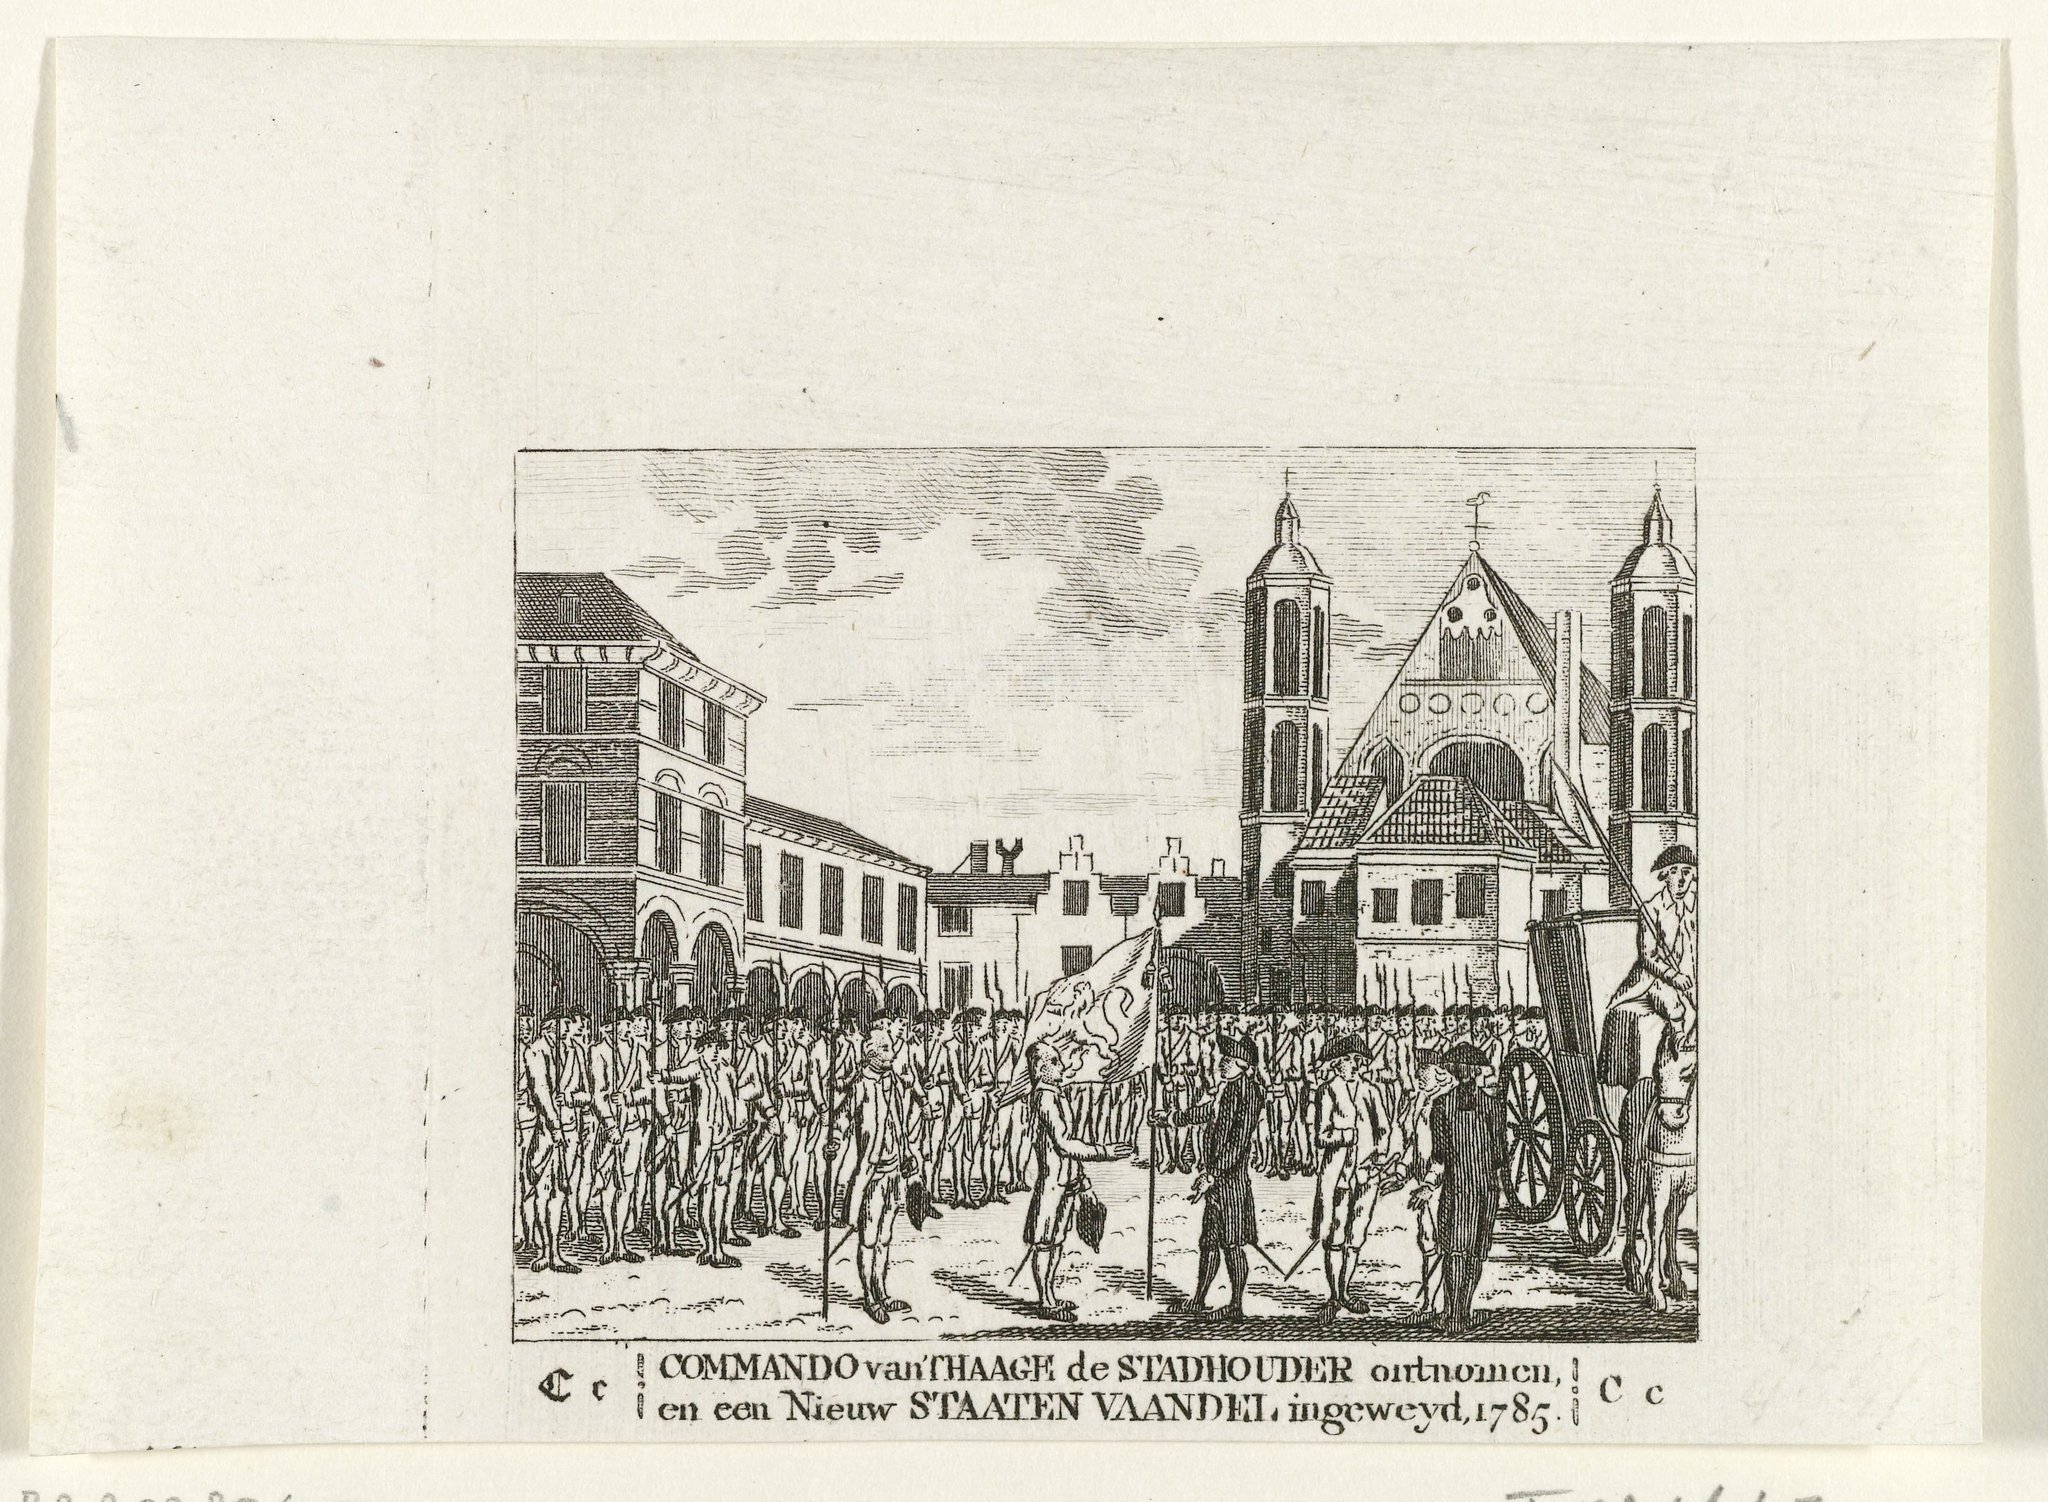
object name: print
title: Commando van 't Haage de Stadhouder ontnomen en een Nieuw Staaten Vaandel ingeweyd, 1785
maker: Anonymous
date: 1787-1790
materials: paper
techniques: etching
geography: northern netherlands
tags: the hague, patriots (1780-1795)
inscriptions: collector's mark: Lugt 2228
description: Burgerkorpsen nemen het militaire commando van Den Haag over van de stadhouder, 8 september 1785. Op het Binnenhof wordt voor de Ridderzaal een nieuw vaandel ingewijd. Plaatje behorend bij de letter C van Commando uit een ABC boek.